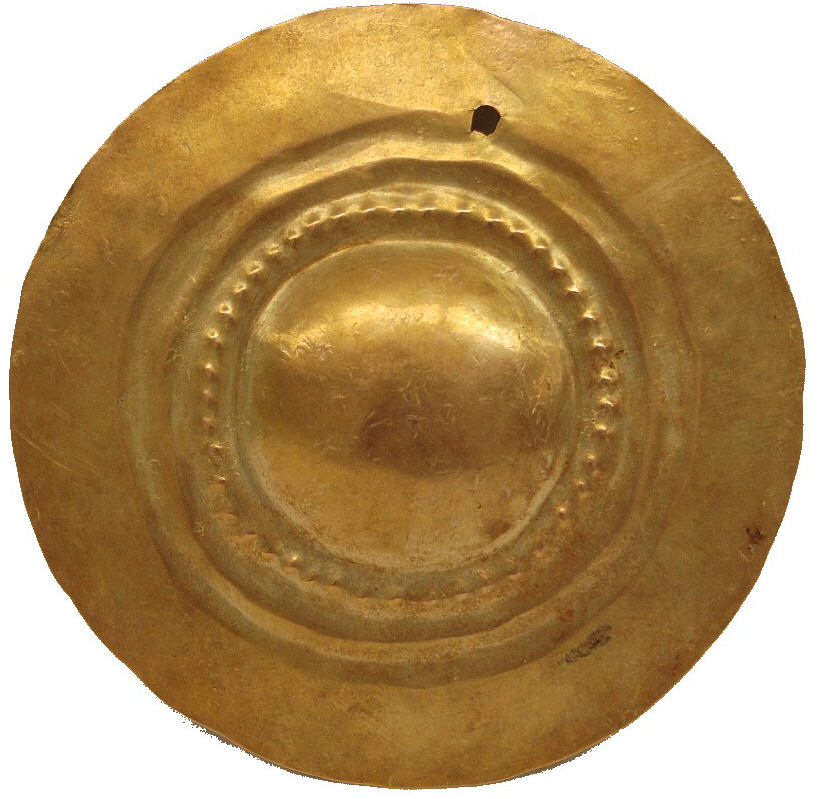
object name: disk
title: Ornamental Disk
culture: capuli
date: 801-1300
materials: gold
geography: ecuador